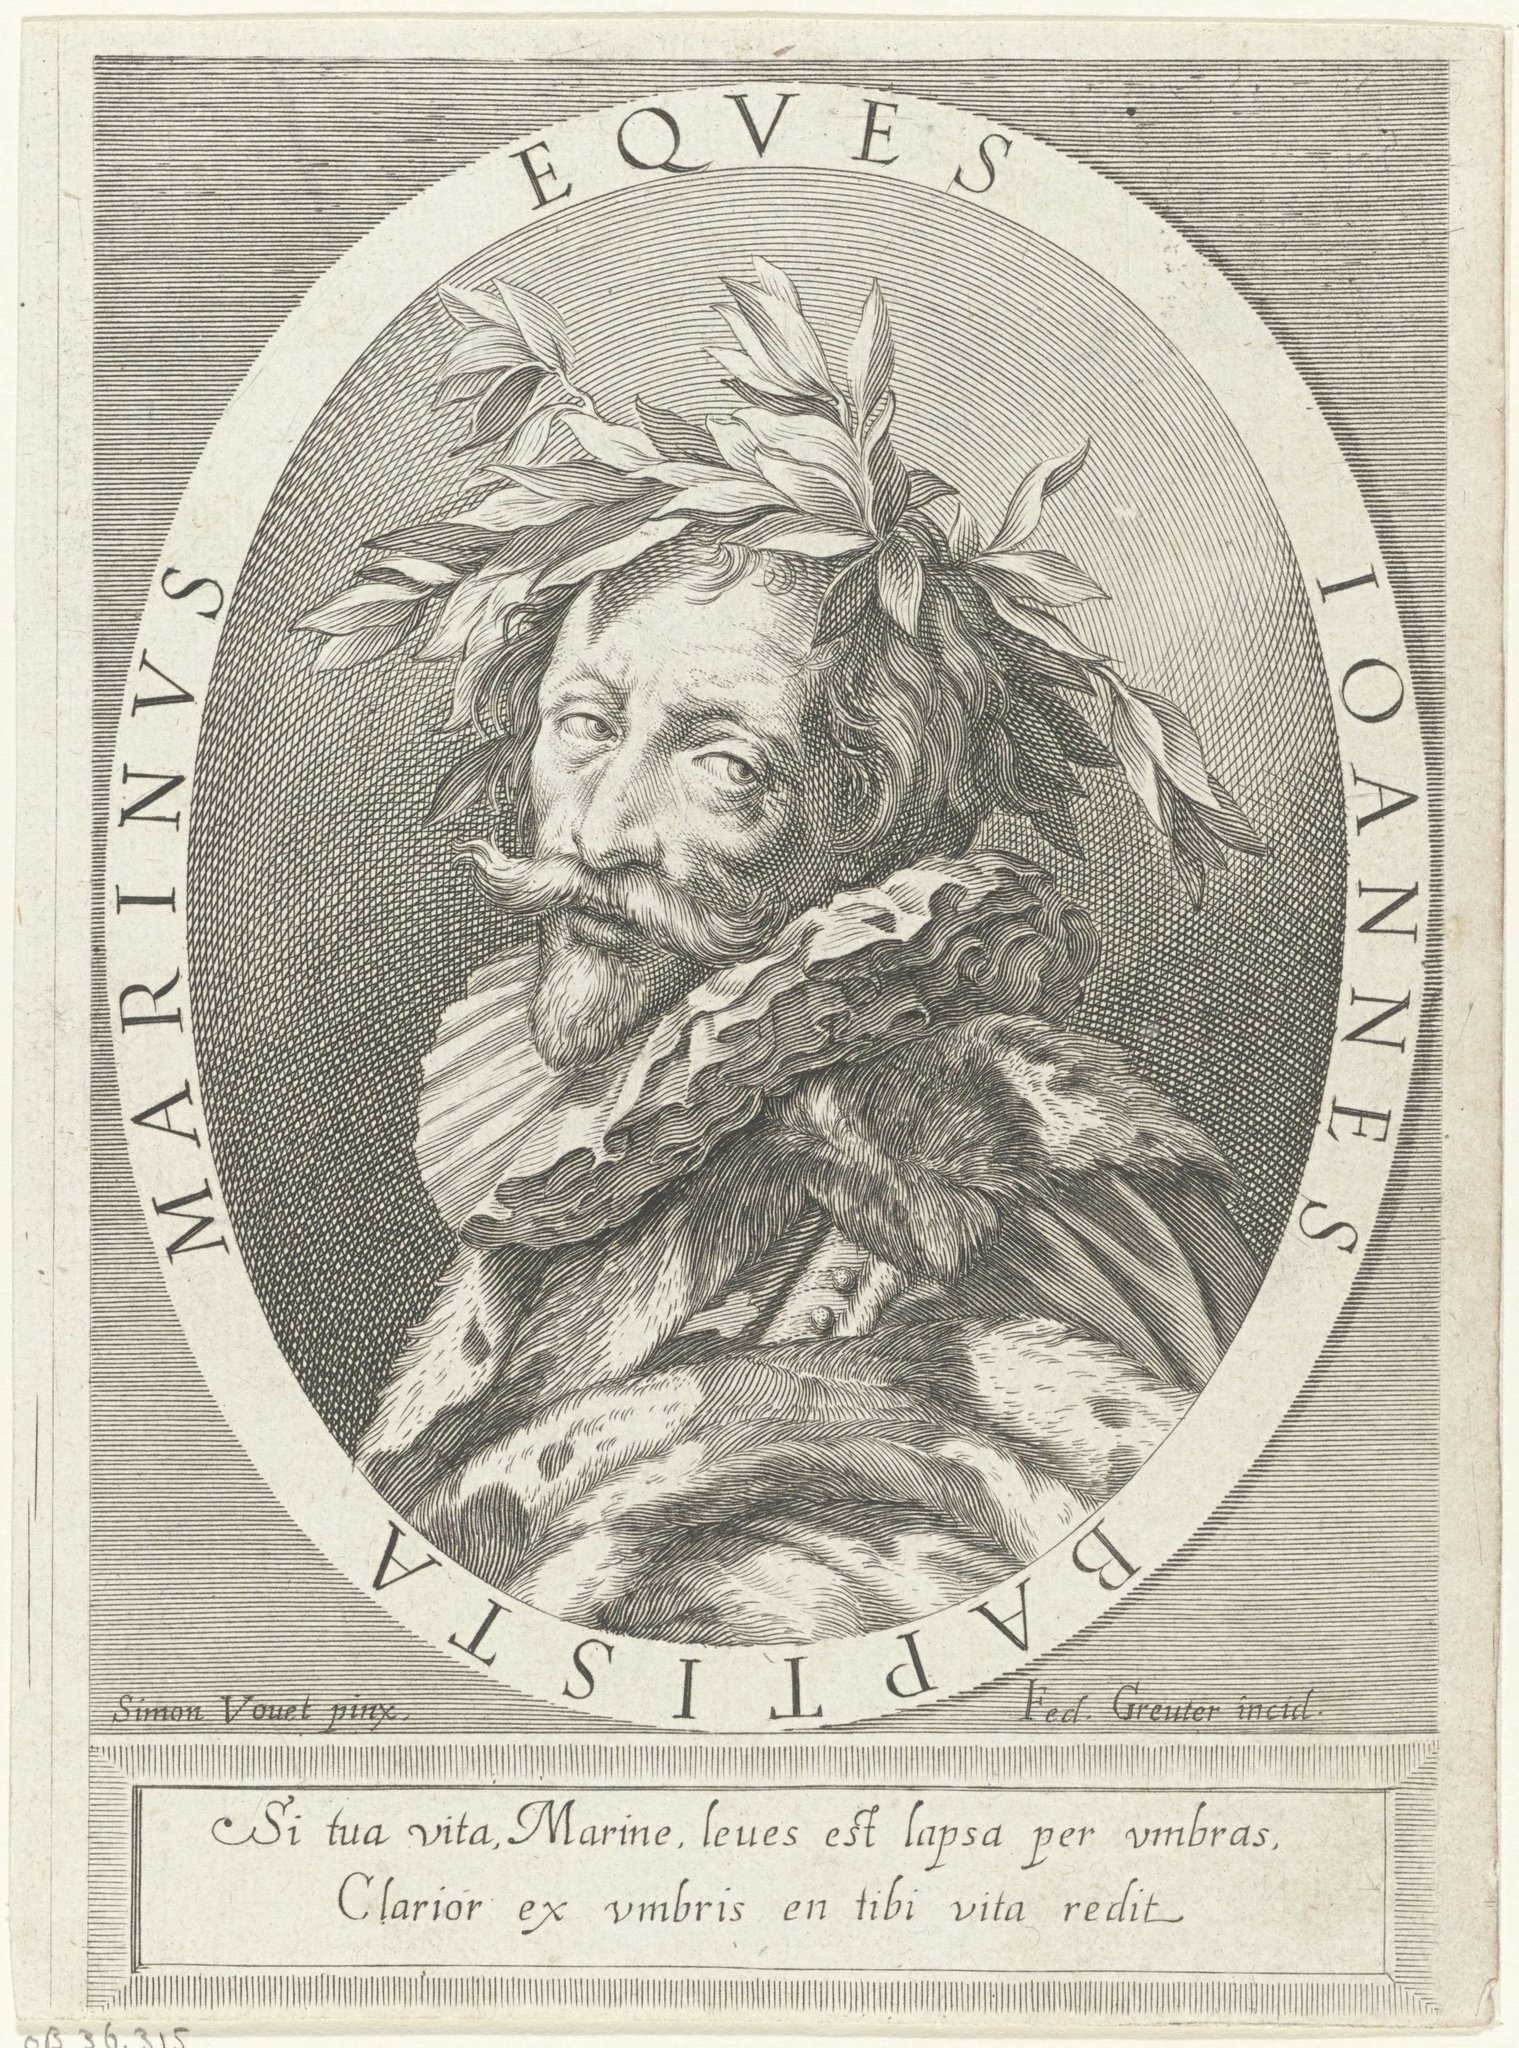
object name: print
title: Portret van dichter Giovanni Battista Marino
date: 1599-1662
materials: paper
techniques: engraving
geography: italy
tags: naples, historical persons, portrait of a writer, writer, poet, author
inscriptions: collector's mark: Lugt 2228